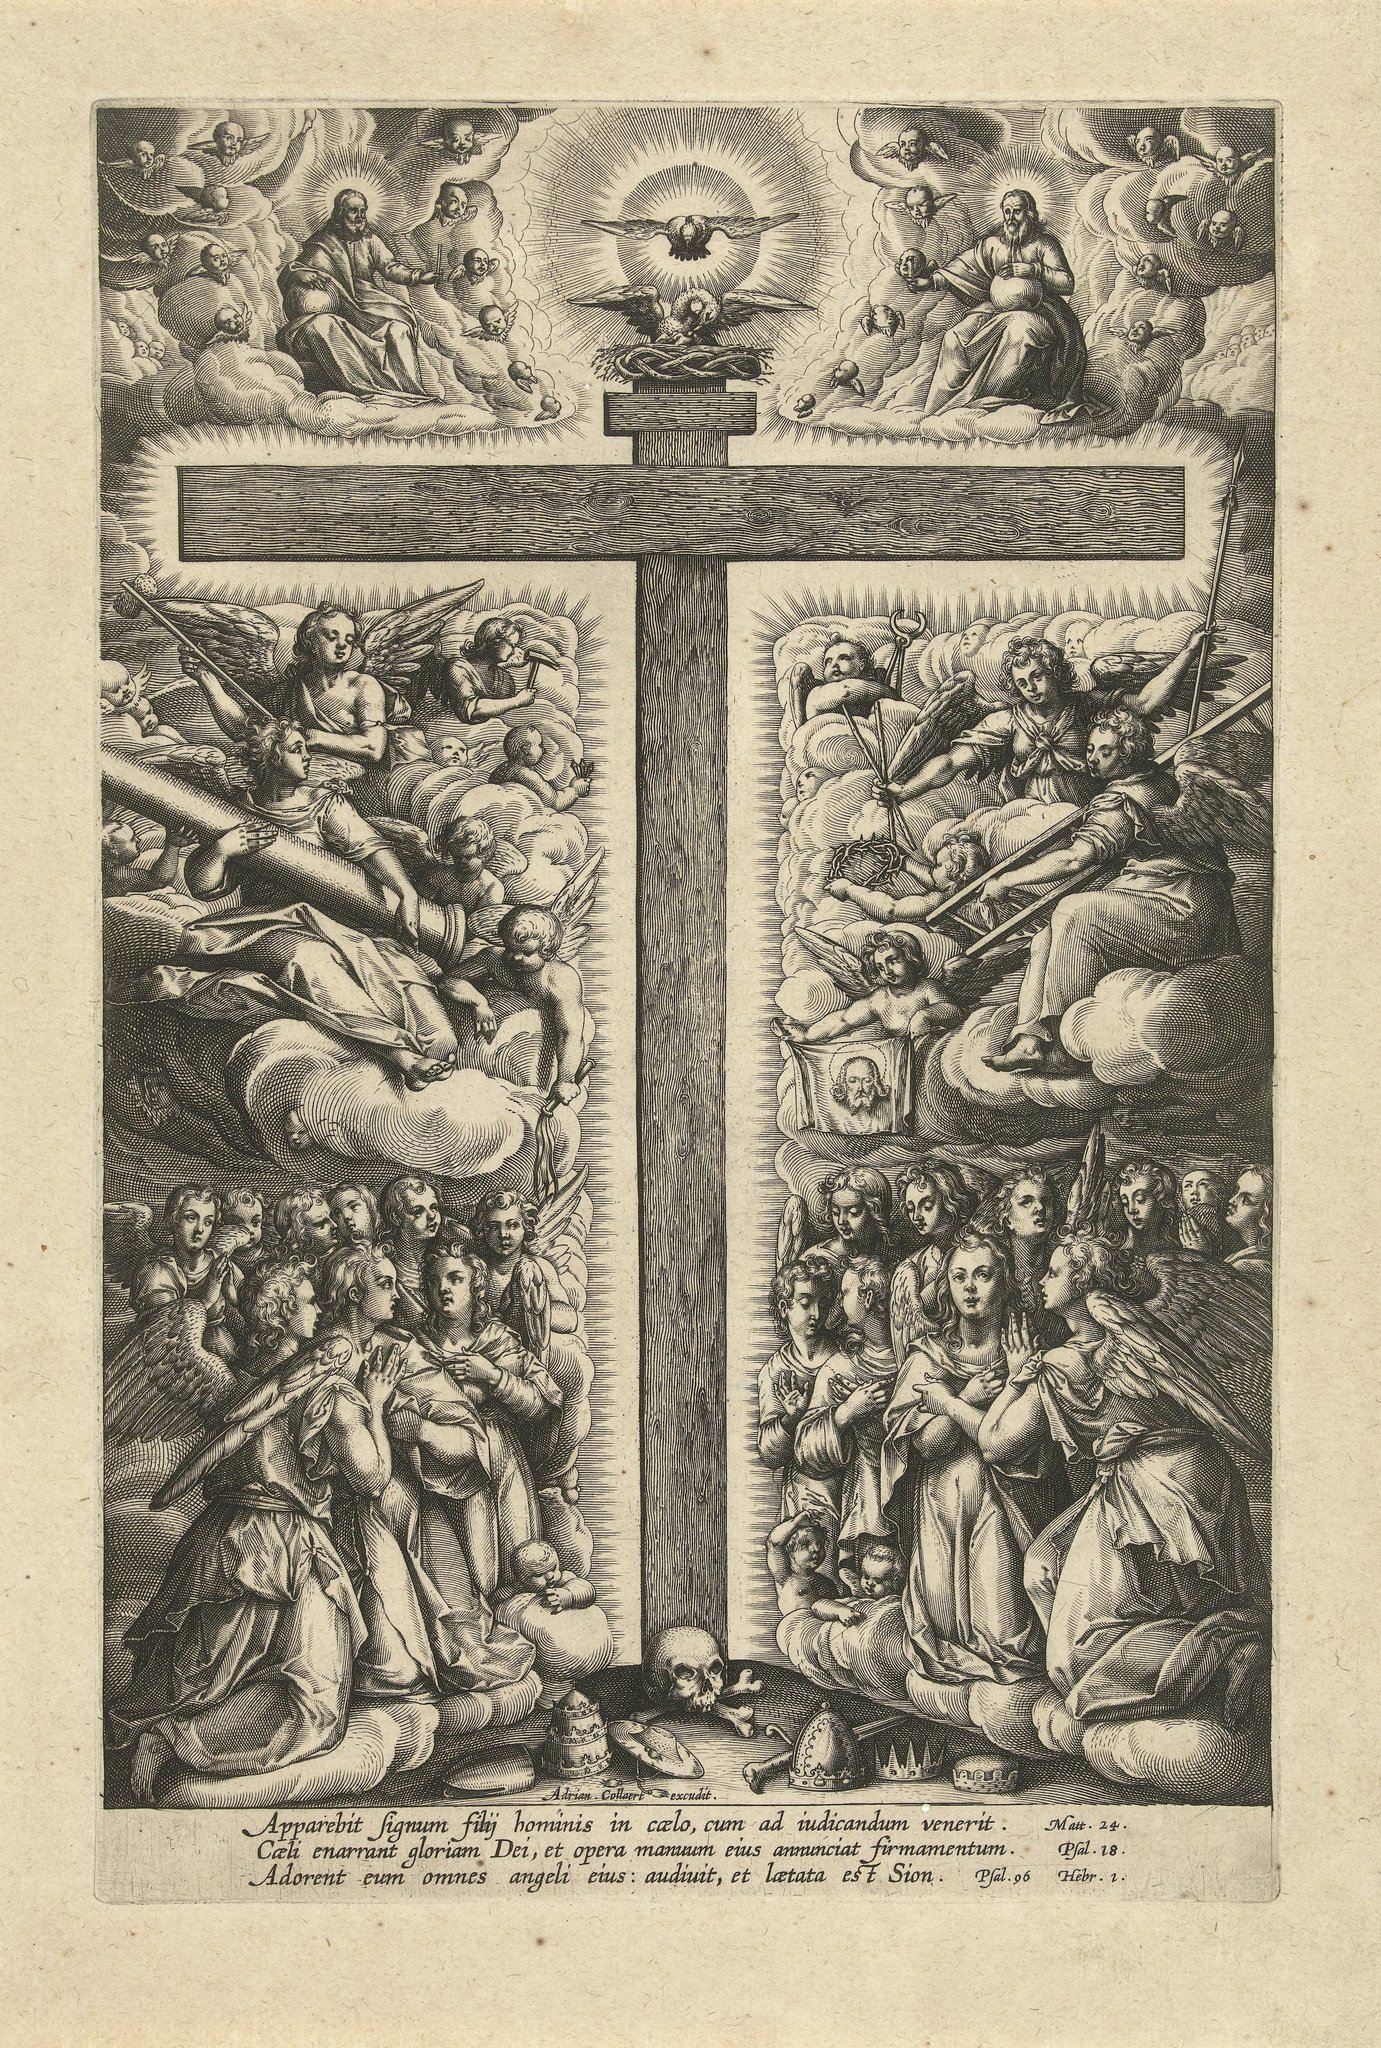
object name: print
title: Aanbidding van het kruis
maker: adriaen collaert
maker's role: draughtsman, print maker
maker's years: 1560-1618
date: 1570-1618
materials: paper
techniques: engraving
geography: antwerp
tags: venerating the cross (+ angel(s)), venerating the cross (+ holy trinity)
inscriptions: collector's mark: Lugt 2228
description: Centraal staat het kruis waaraan Christus is gestorven. Links en rechts van het kruis engelen met de passiewerktuigen in hun handen. Onderaan het kruis rouwende engelen. Boven het kruis de Heilige Drie-eenheid in de wolken.Op het kruis zit een pelikaan die zijn borst doorboort om zijn jongen te voeden met zijn bloed, een symbool voor Christus' zelfopoffering.